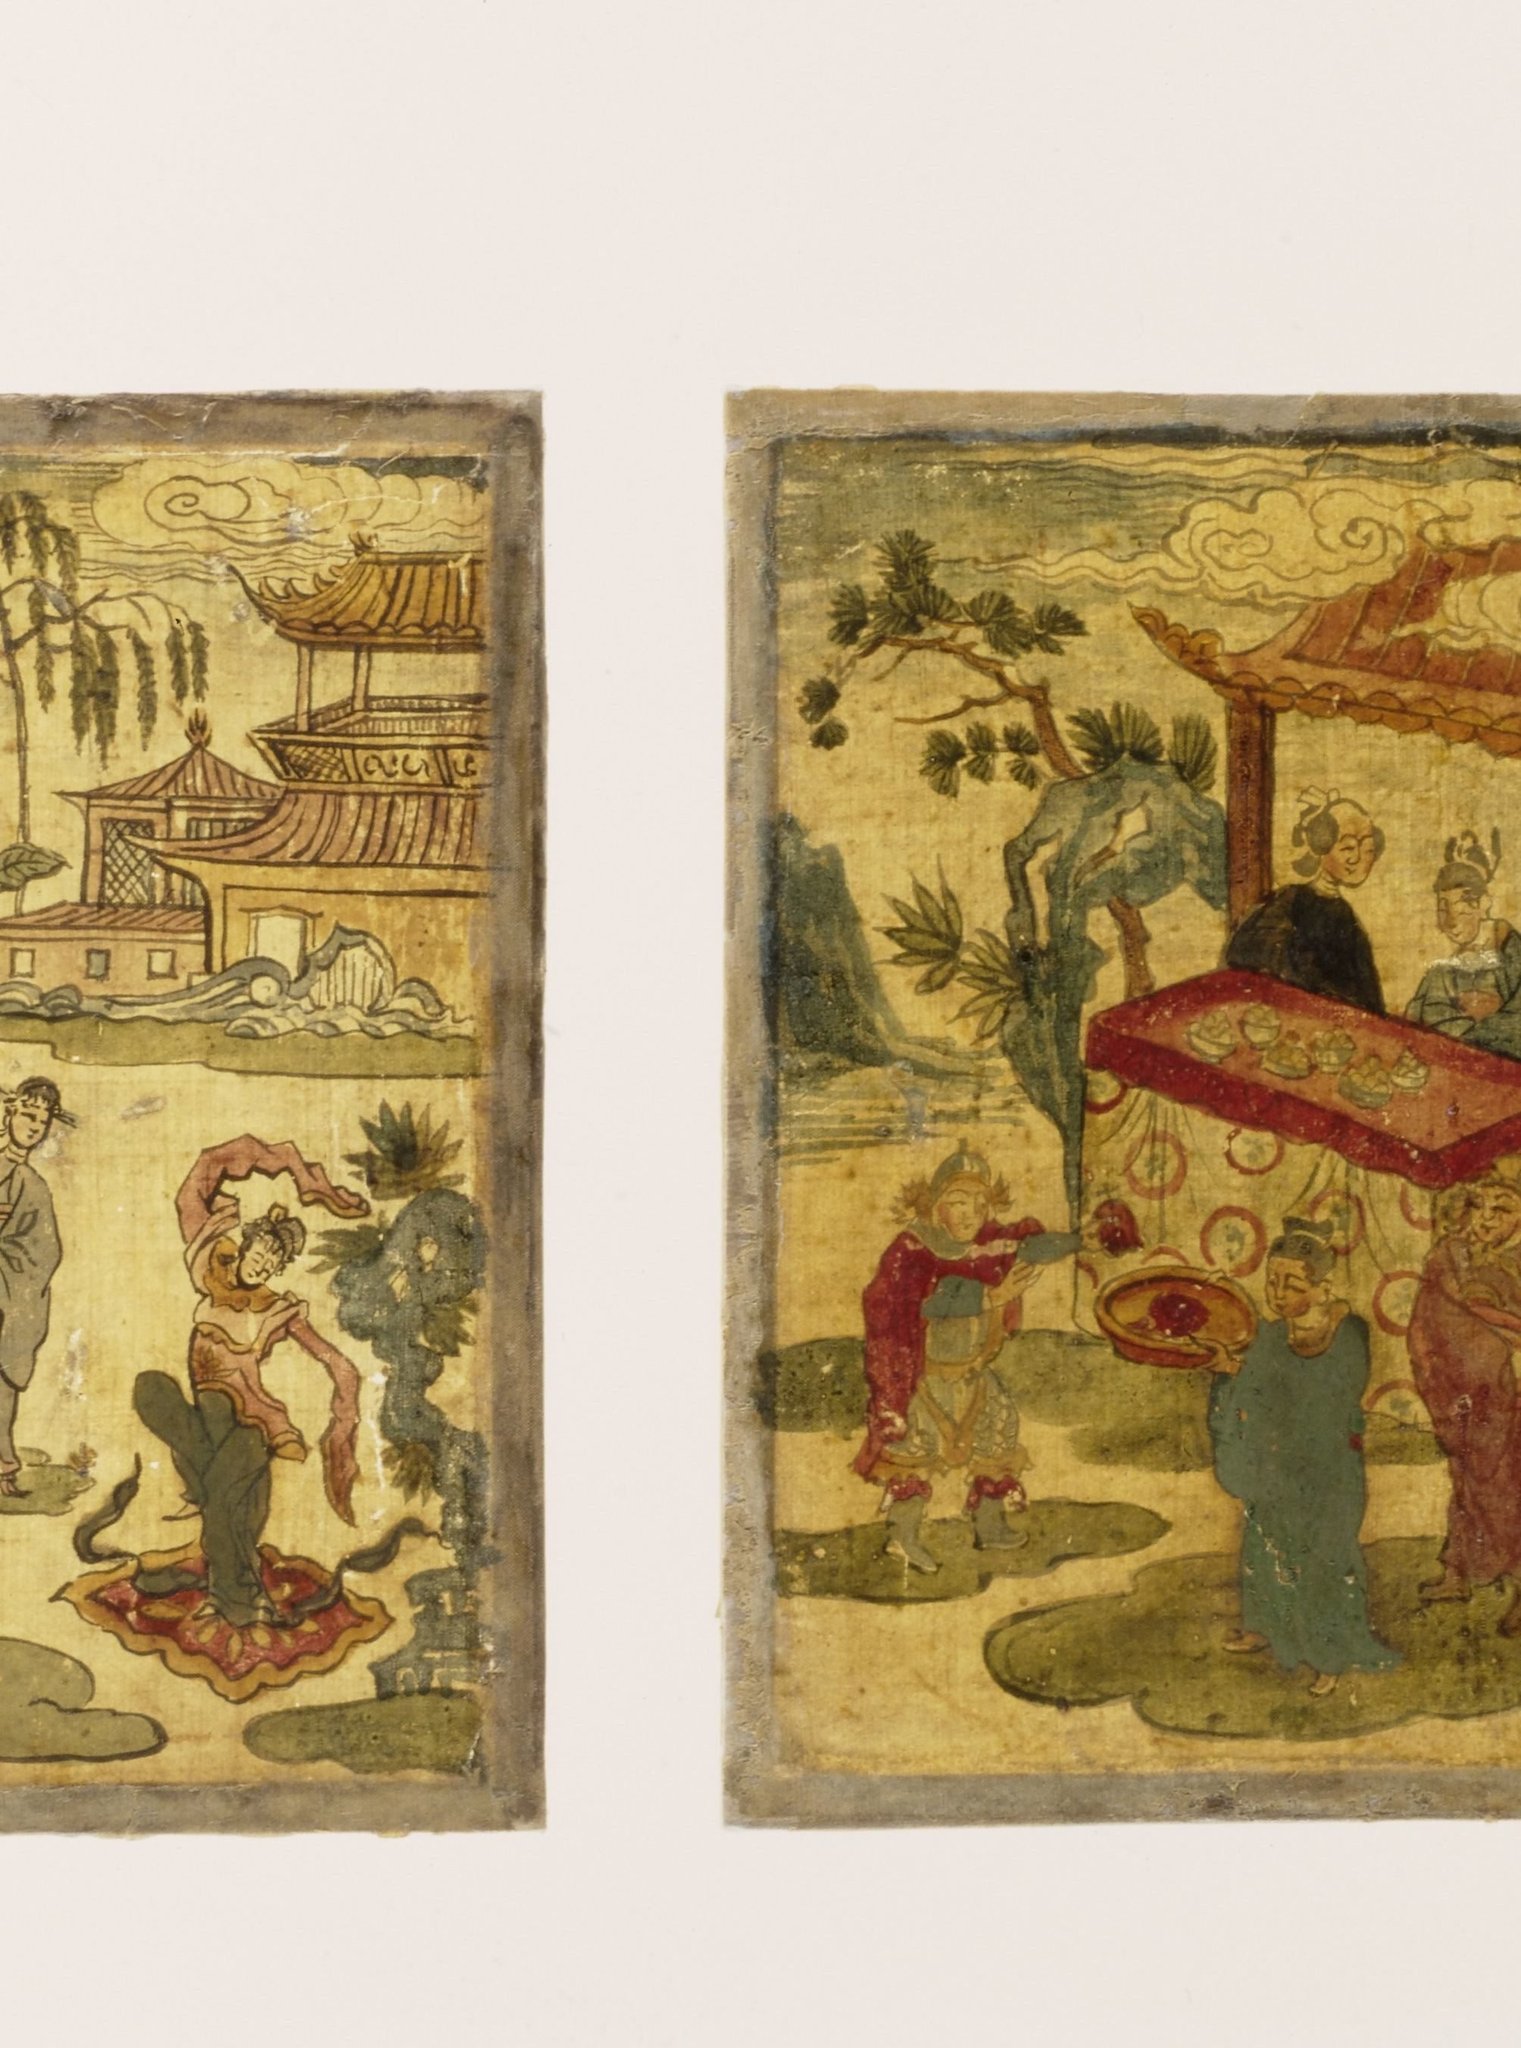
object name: storm window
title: Voorzetraam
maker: Anonymous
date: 1702-1710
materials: gouache, resin, silk, wood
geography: amsterdam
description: Sassinet of beschilderde voorzetraam; vervaardigd uit een smal houten raamwerk, bespannen met crème-kleurige zijde die beschilderd is met Chinoiserieën. De voorstelling is ontleent aan een ornament prent uit een serie van Petrus Schenk sr: de 'Picturae Sinicae ac Surattenae' etc., verschenen in Amsterdam in 1702, waarbij landschappen en daken bij gefantaseerd zijn. Opmerking: zie BK-NM-1010-246-C en D. (serie nr. 10b)